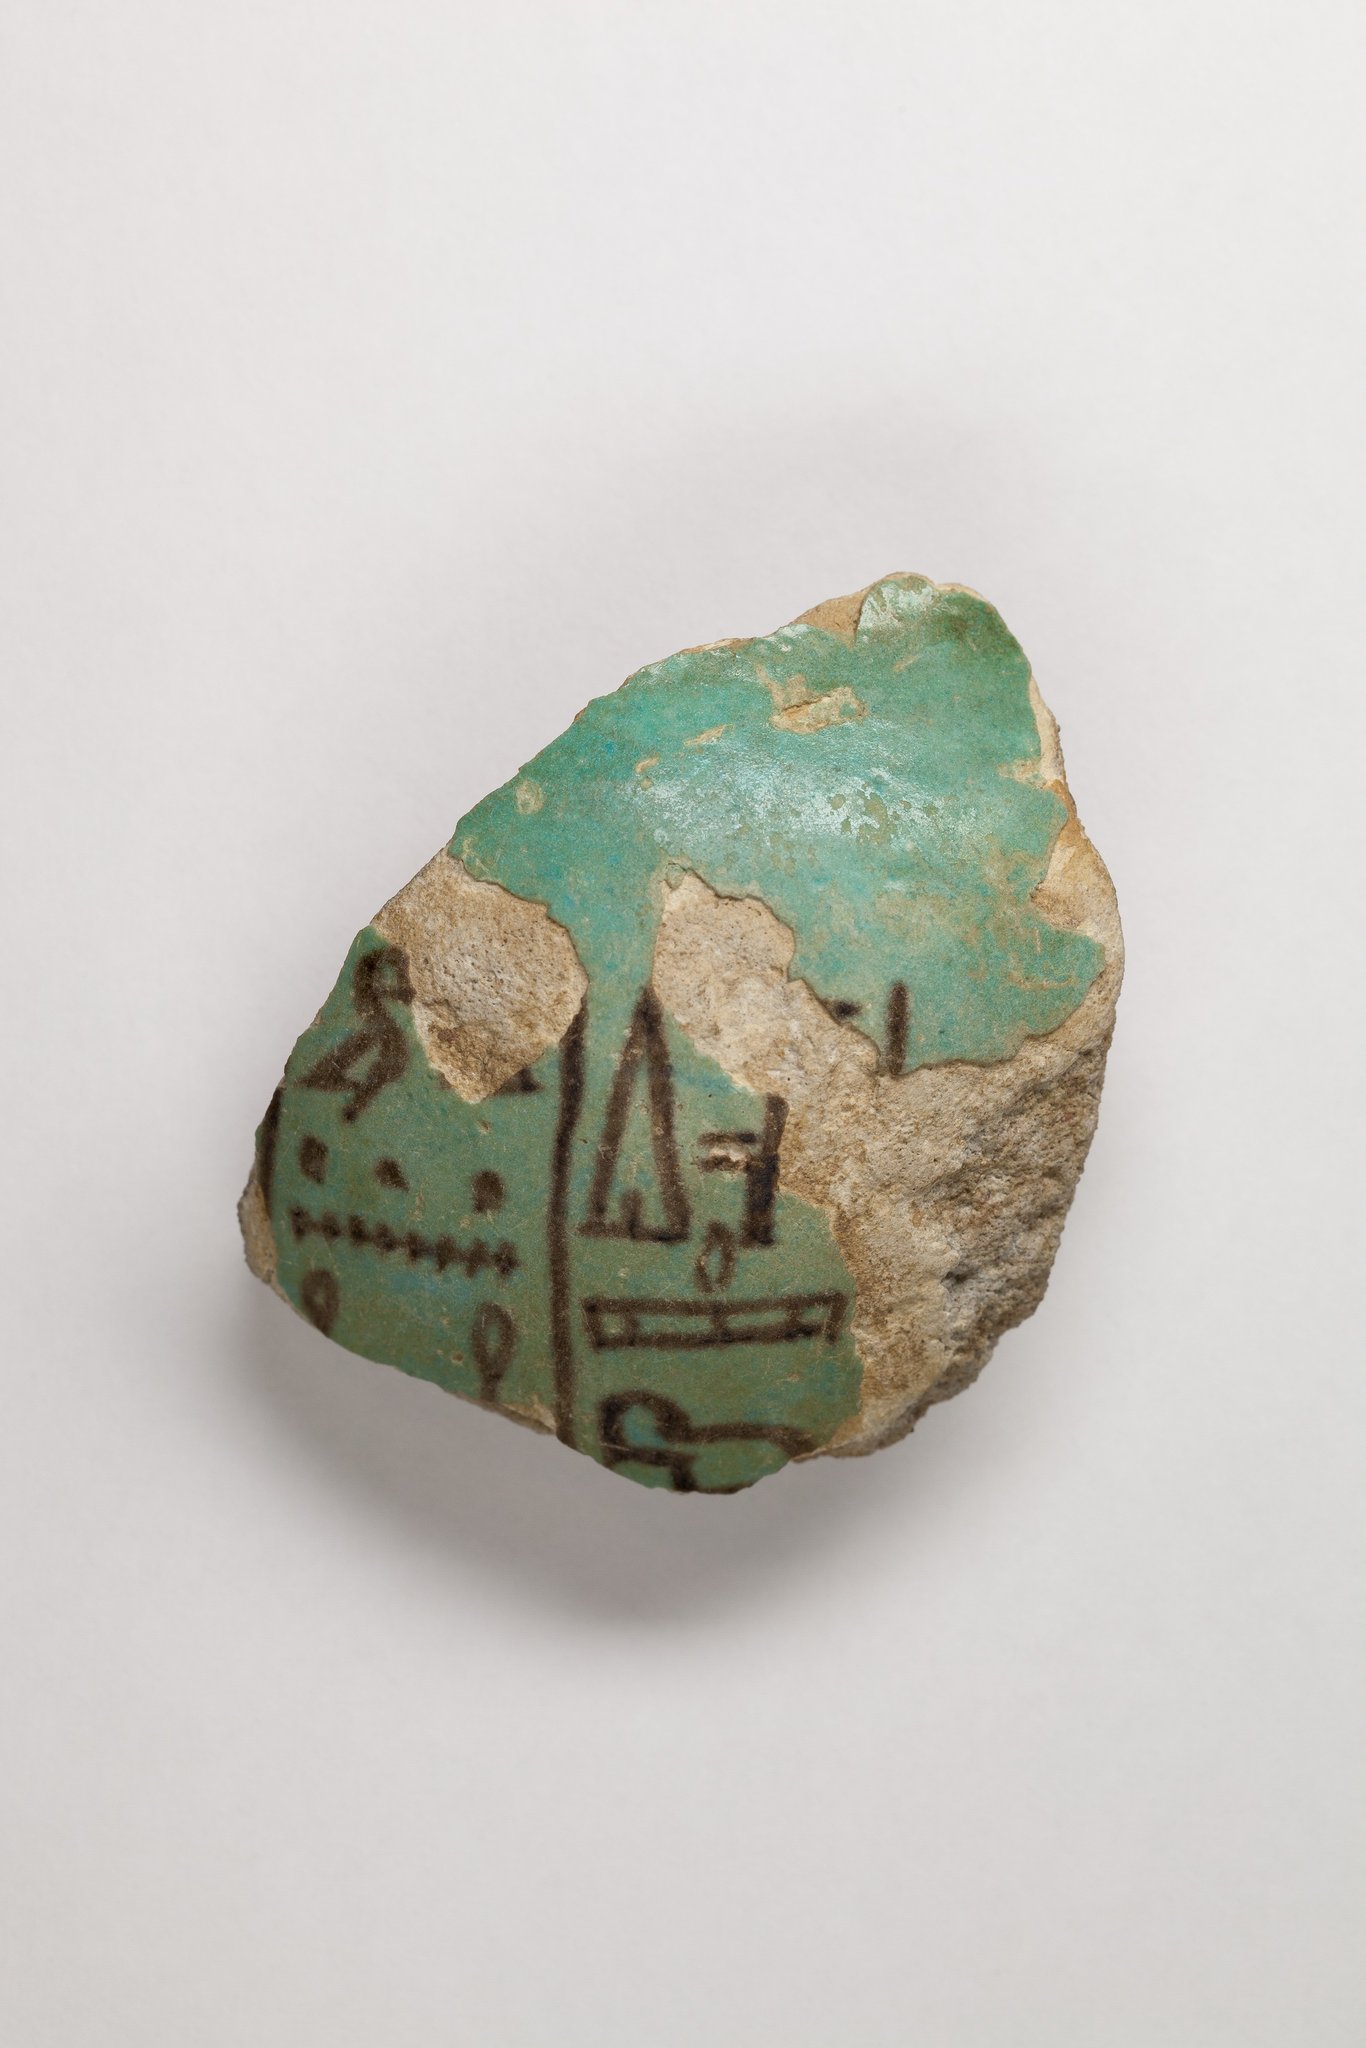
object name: vase fragment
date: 1981-1640 BCE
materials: faience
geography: egypt